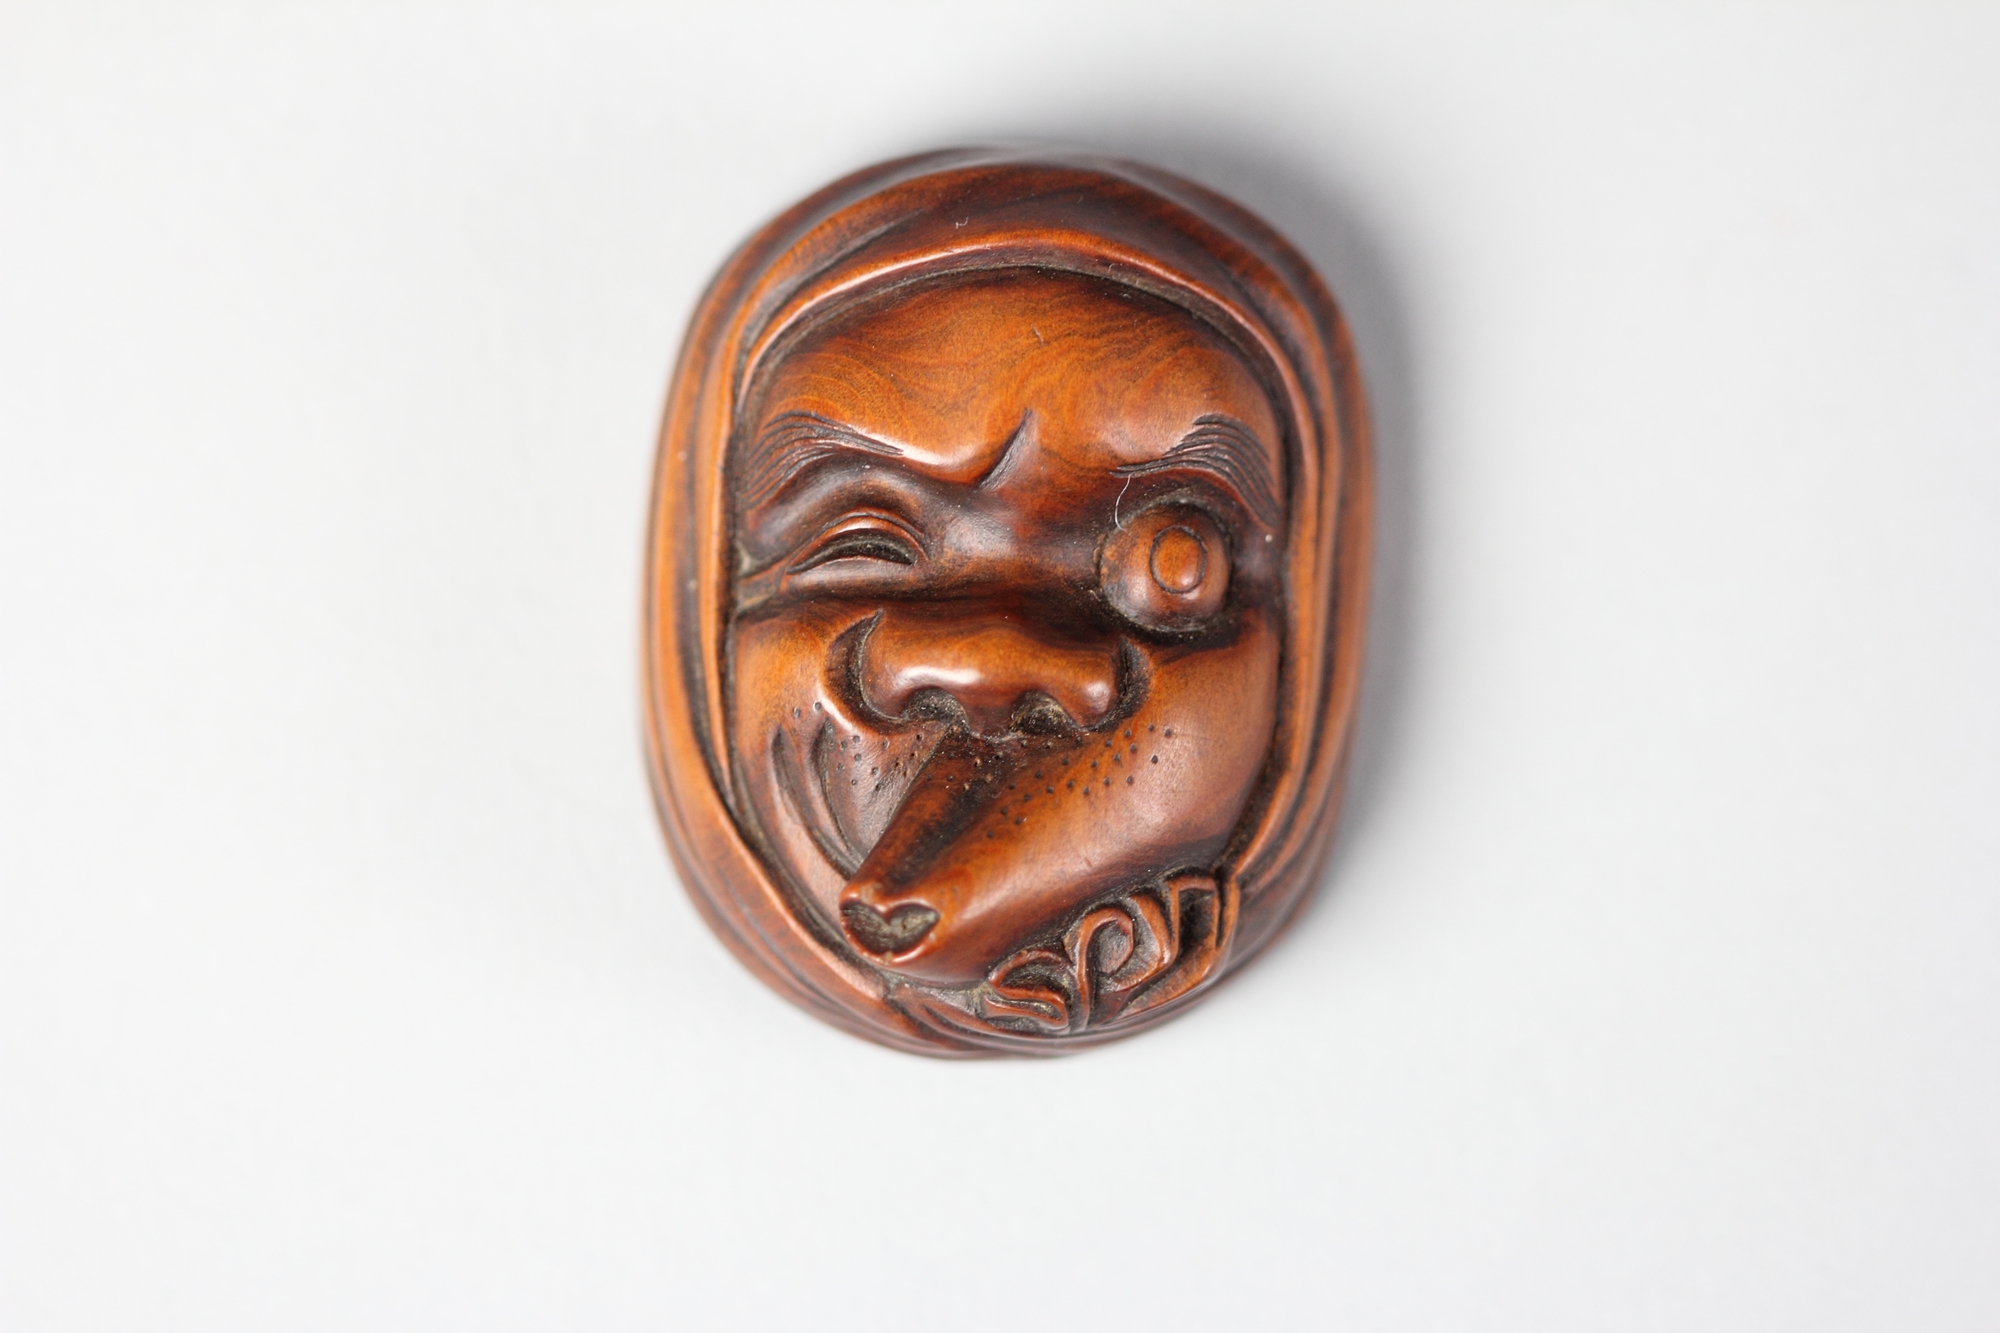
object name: netsuke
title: Netsuke of Noh Mask: One-Eyed Hyottoko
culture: japanese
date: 1801-1900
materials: wood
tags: masks